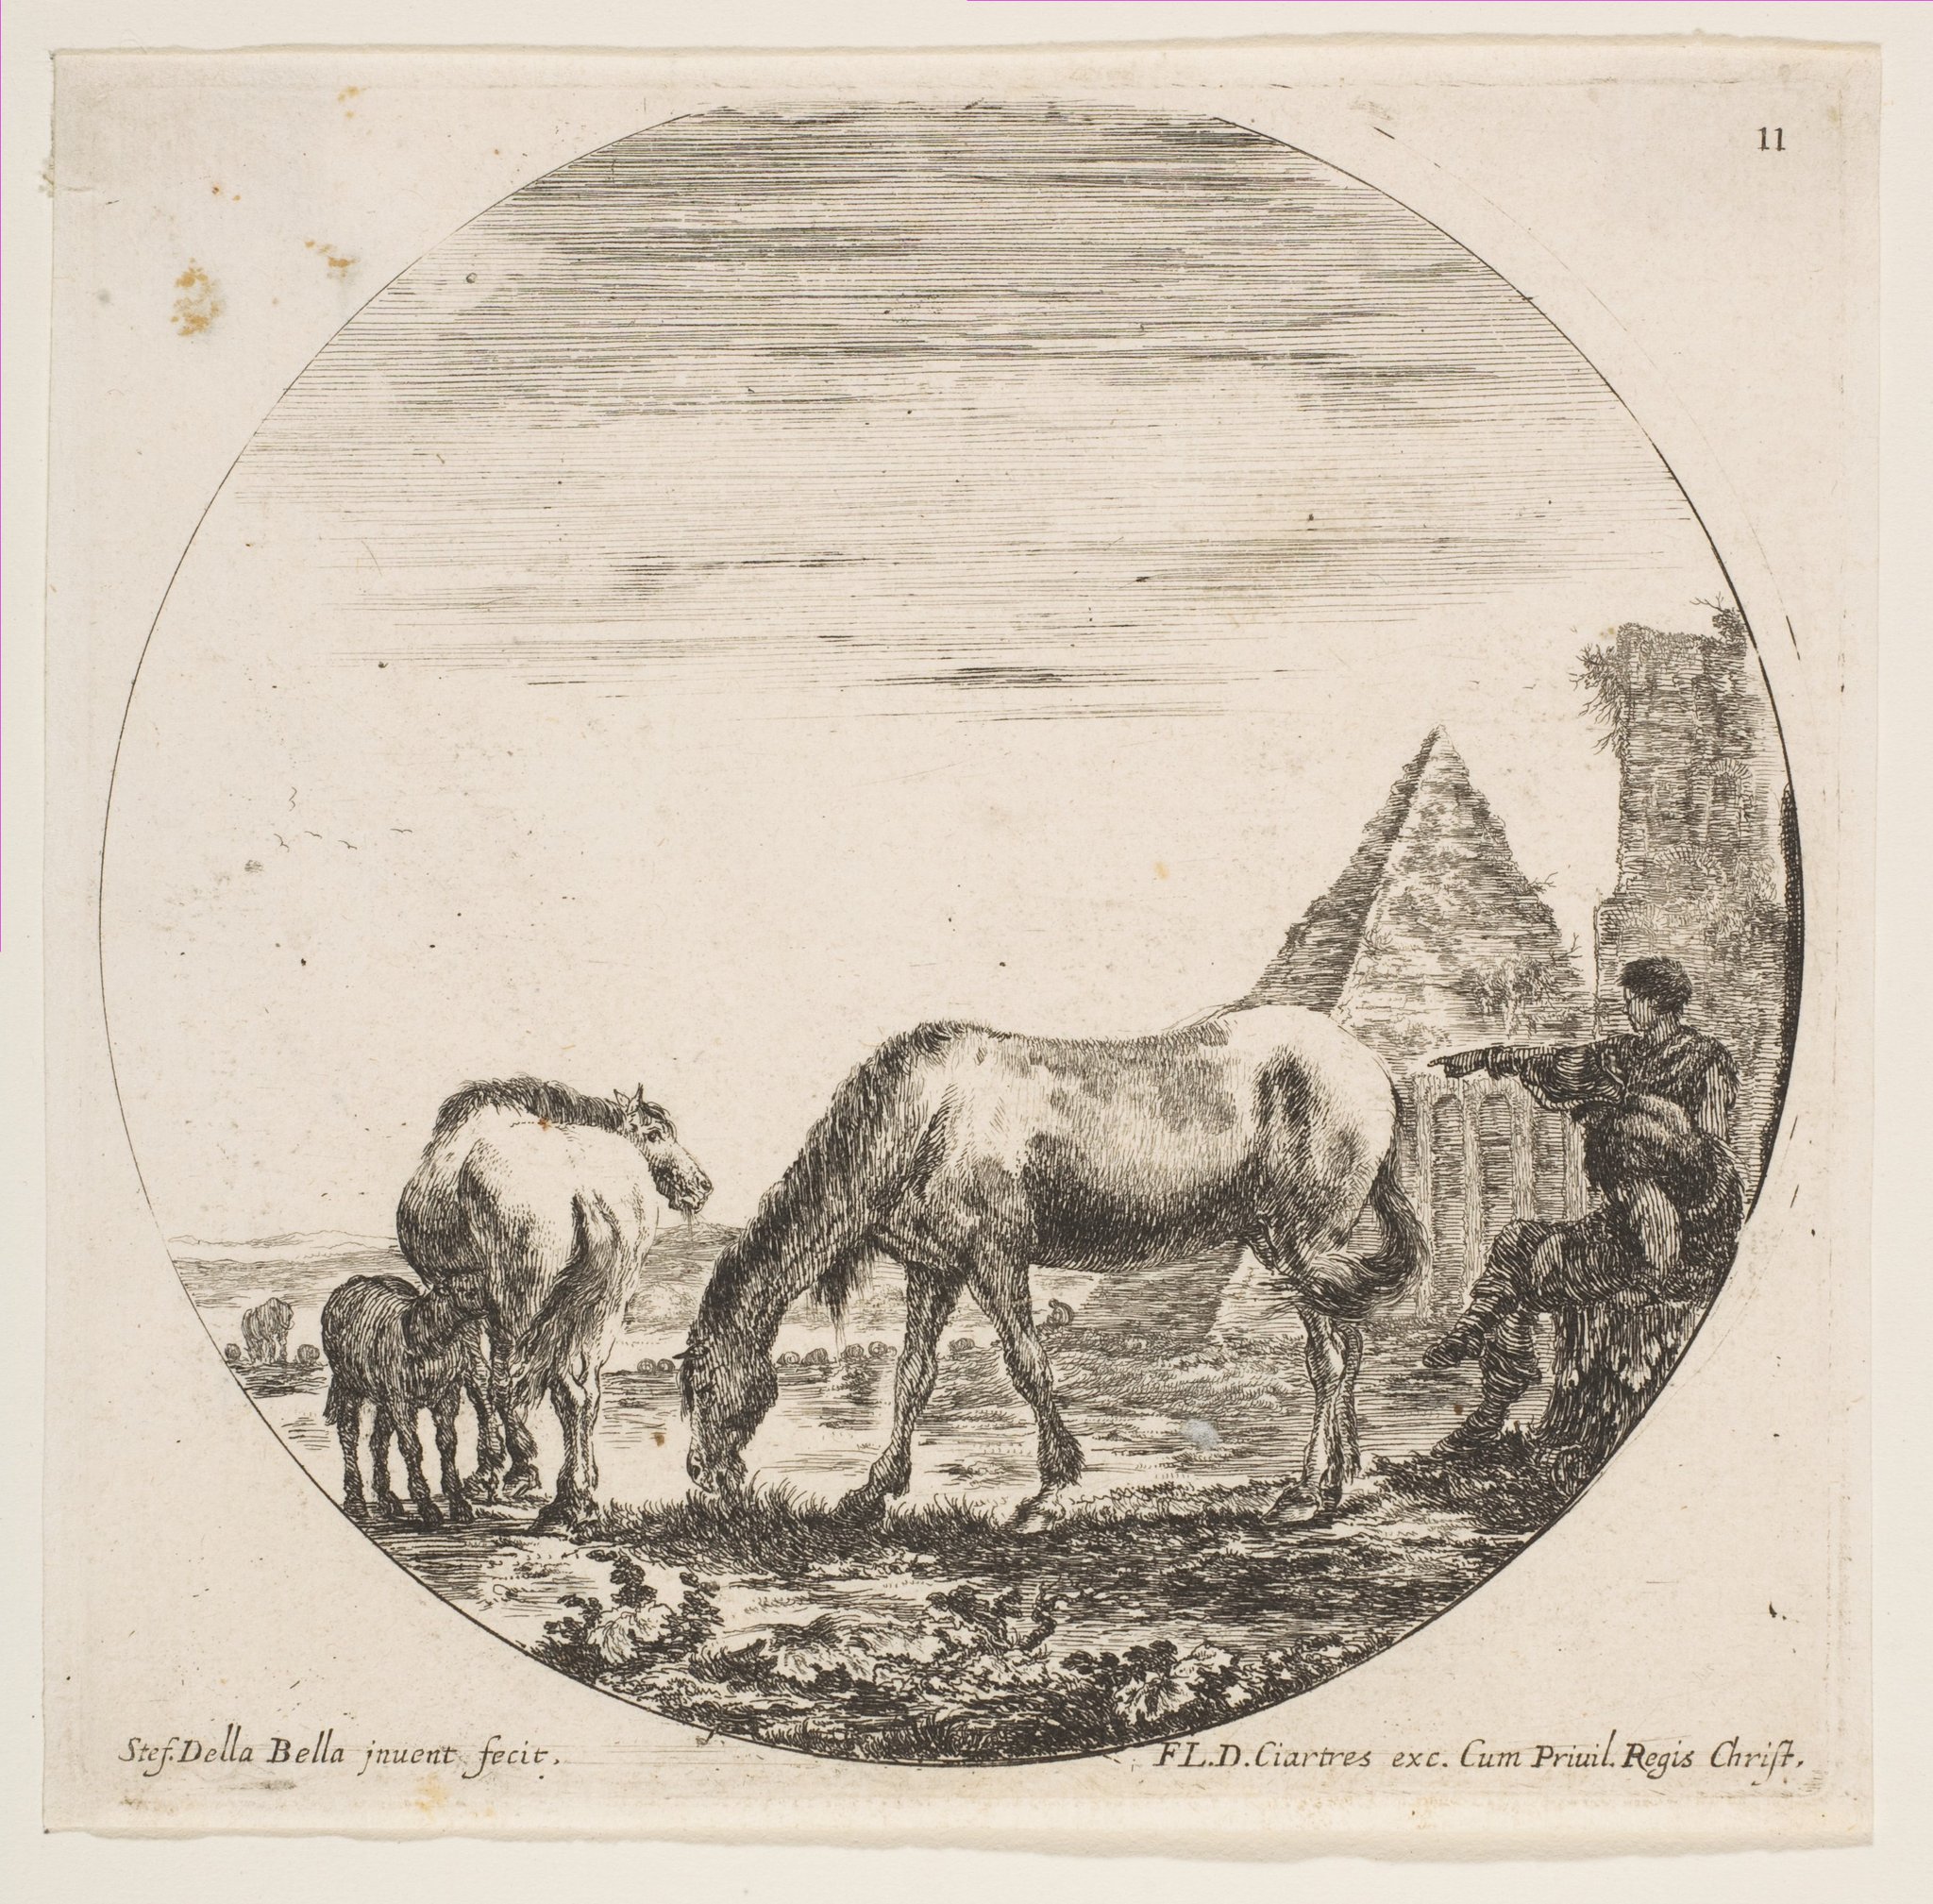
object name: print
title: The pyramid of Caius Cestius at right in the background, a horse grazing at center, a foal suckling a mare at left, two shepherds at right, plate 11 from "Roman landscapes and ruins" (Paysages et ruines de Rome)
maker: stefano della bella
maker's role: artist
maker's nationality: italian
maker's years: 1610-1664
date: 1646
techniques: etching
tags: human figures,horses